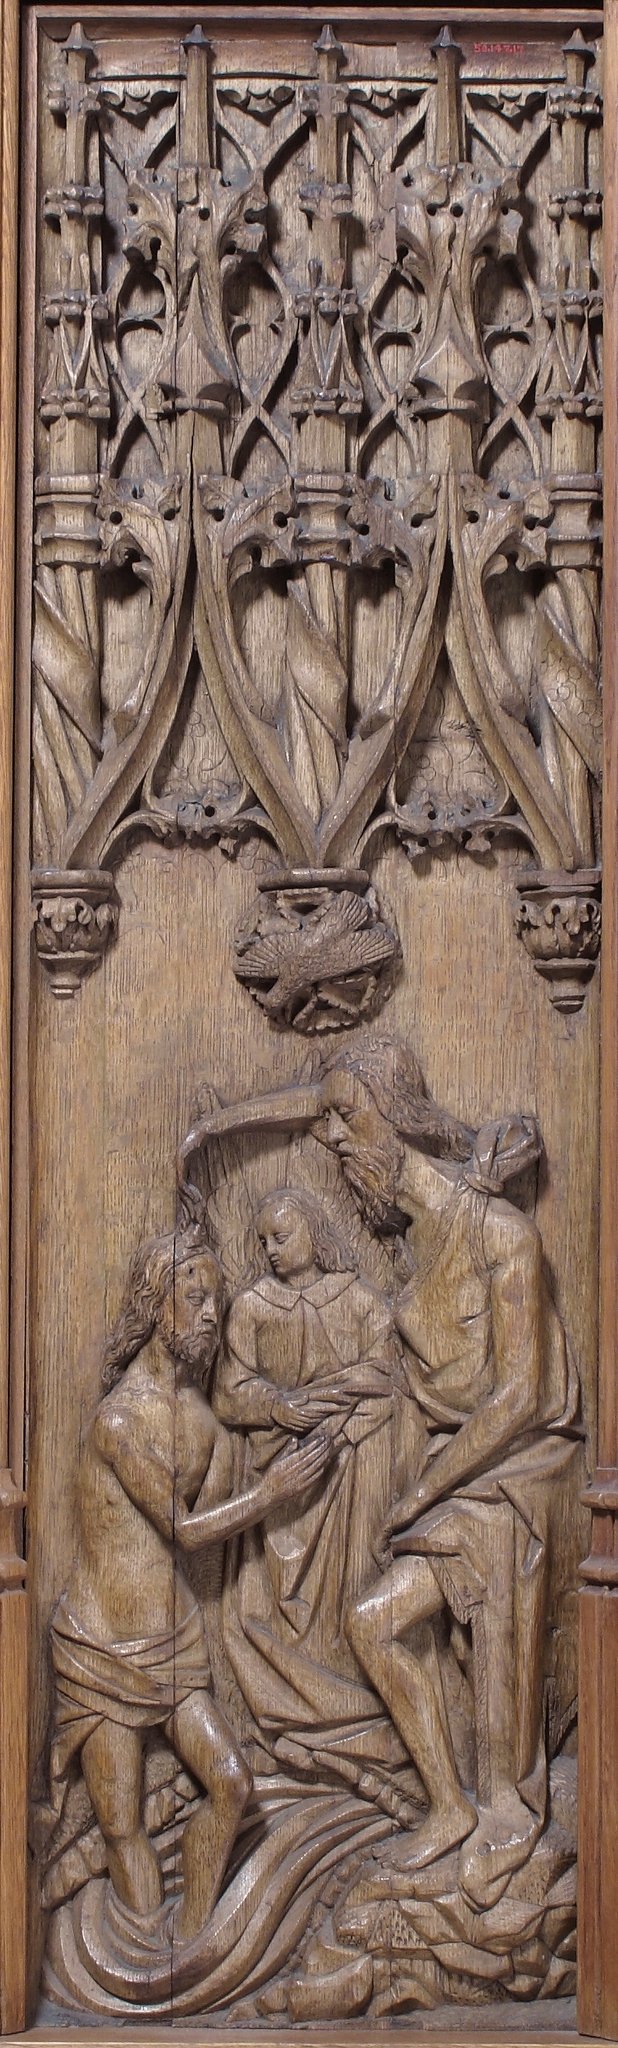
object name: panel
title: Panel with the Baptism of Christ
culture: french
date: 1501-1533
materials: wood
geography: france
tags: men,christ,baptism of christ